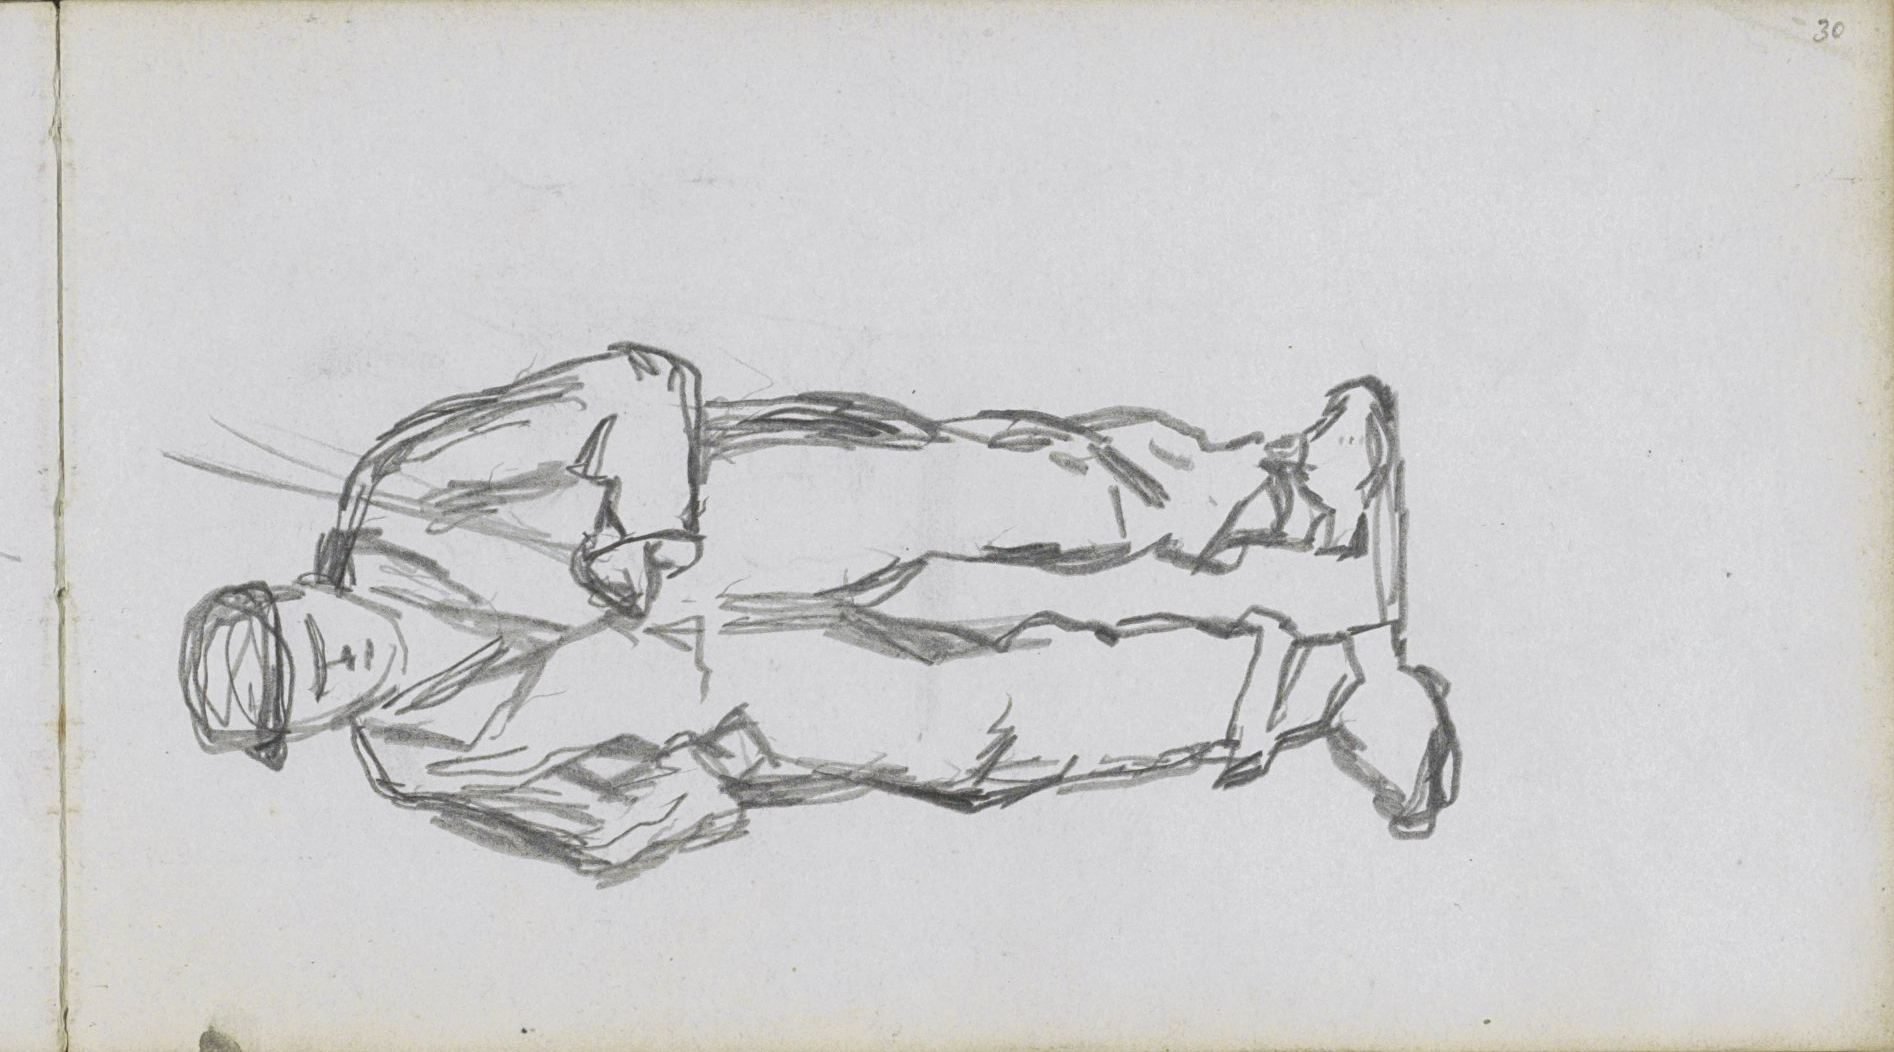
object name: sketchbook leaf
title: Lopende man op klompen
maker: johan hendrik weissenbruch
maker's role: draughtsman, painter, print maker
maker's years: 1824-1903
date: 1834-1903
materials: paper, pencil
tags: walking (+ adult male (human being)), wooden shoes, clogs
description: Blad 30 recto uit een schetsboek met 39 bladen.